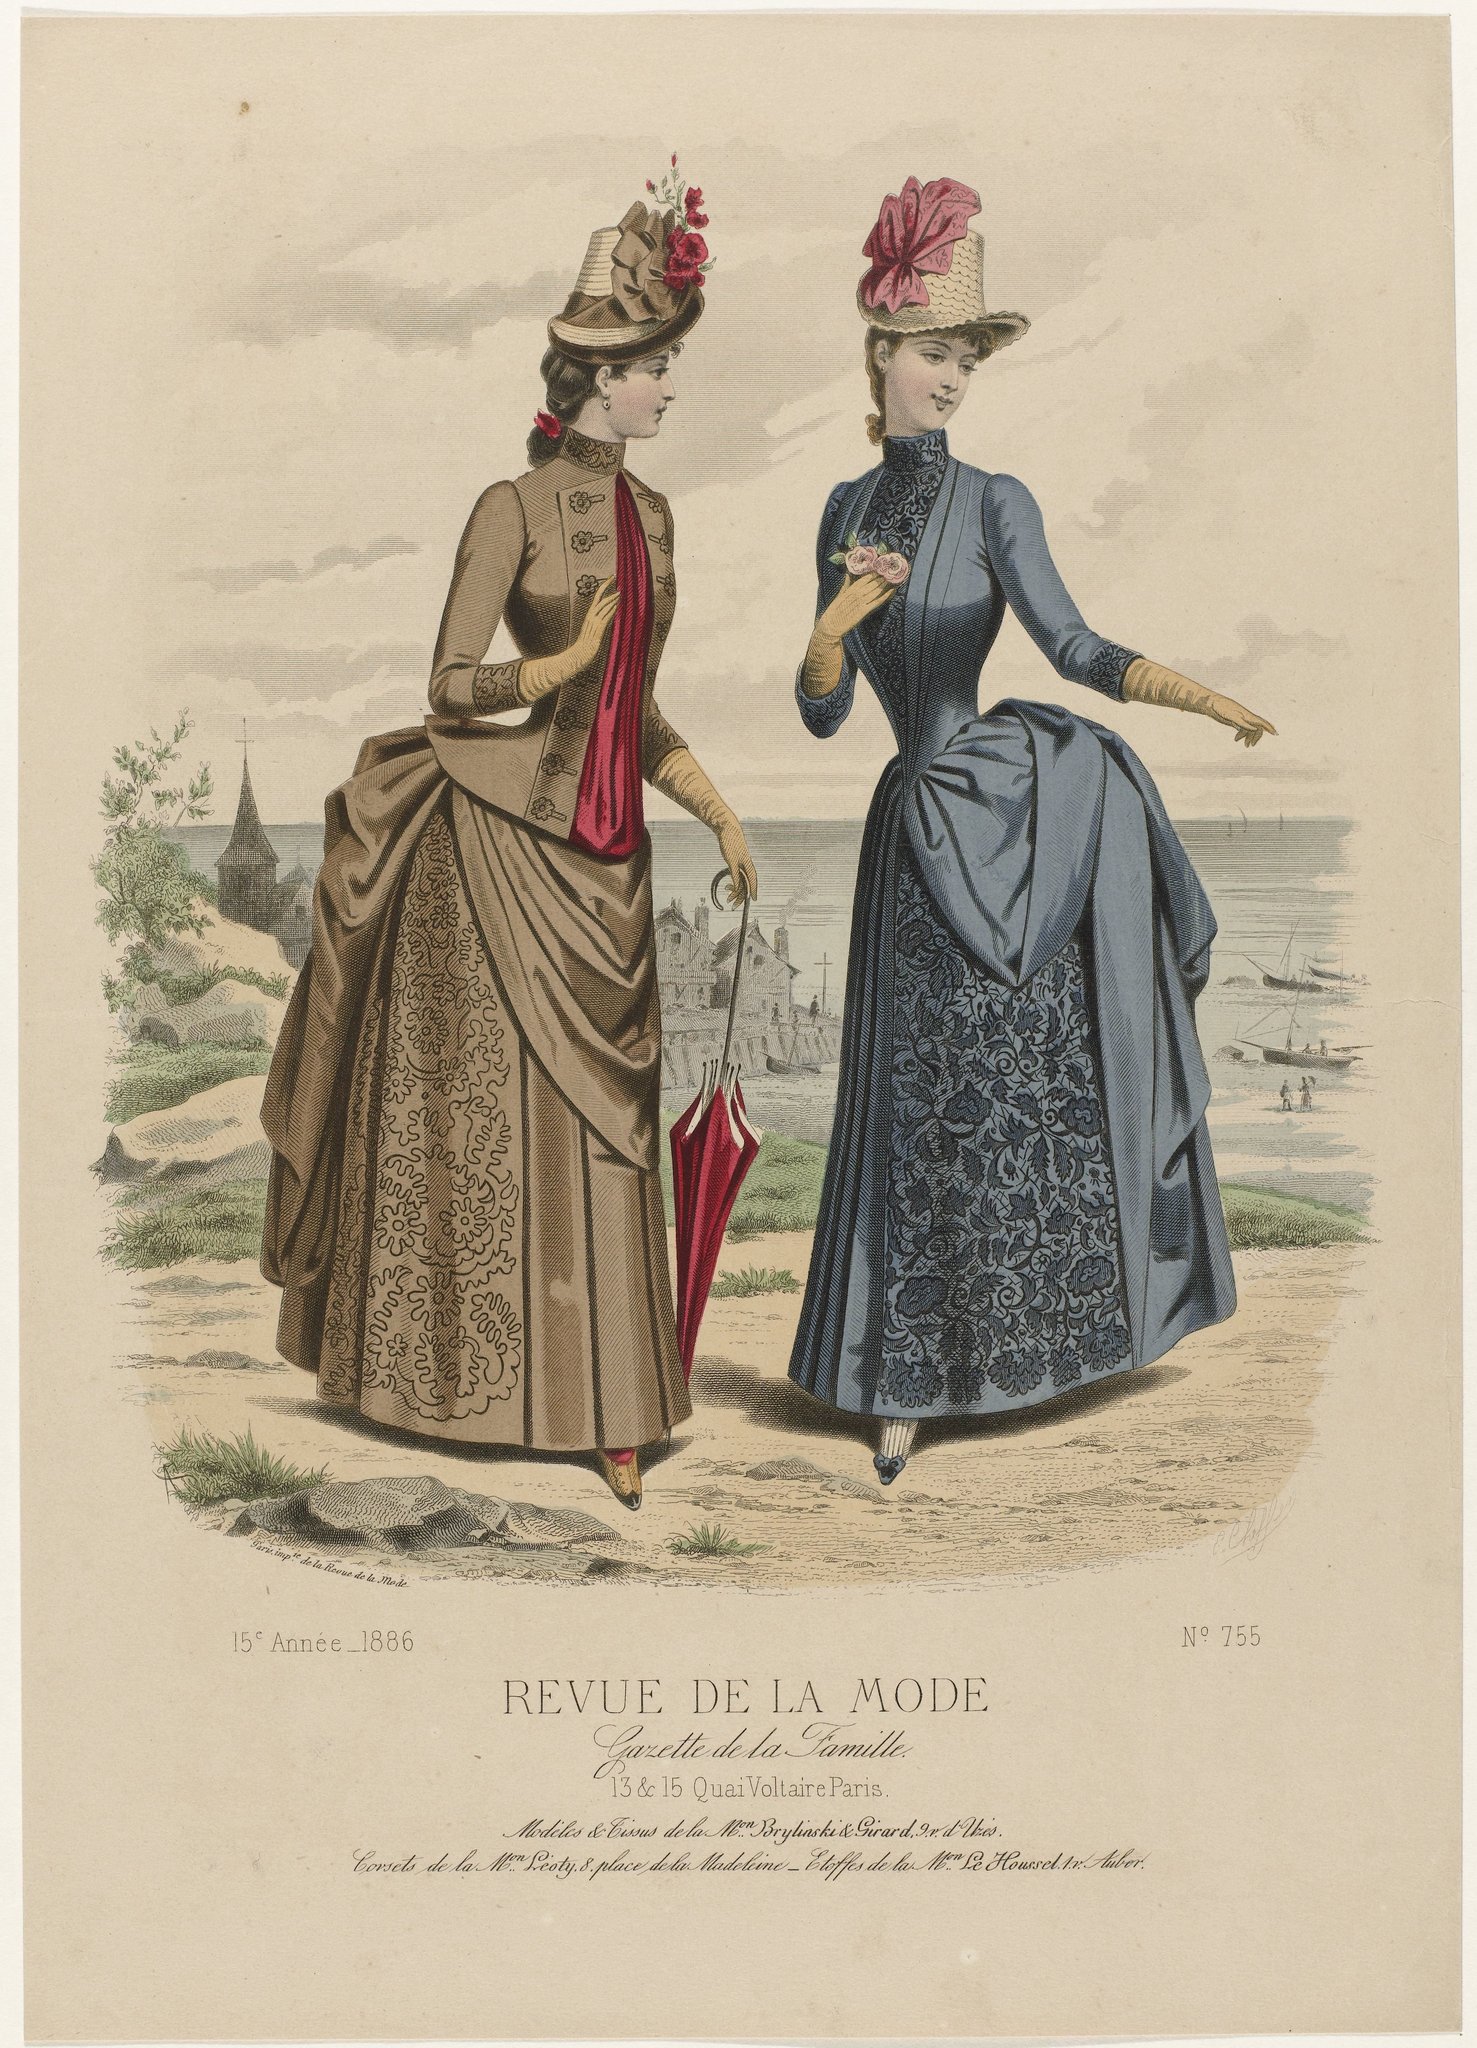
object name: fashion print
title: Revue de la Mode, Gazette de la Famille, dimanche 20 juin 1886, 15e Année, No. 755: Modèles & Tissus (...)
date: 1886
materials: paper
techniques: engraving, hand coloring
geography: paris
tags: beach (as place of recreation), cut flowers; nosegay, bunch of flowers, gloves, mittens (long gloves) (+ women's clothes), walking-stick, staff, cane (+ women's clothes), fashion plates, head-gear: hat (+ women's clothes), skirt (+ women's clothes), dress, gown (+ women's clothes)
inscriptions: title: ‘REVUE DE LA MODE / Gazette de la Famille’, caption: ‘Modèles & Tissus de la M.on Brylinski & Girard, 9, r. d'Uzés. Corsets de la M.on Léoty, 8, place de la Madeleine_ Etoffes de la M.on Le Houssel, 1, r. Auber.’, address: ‘13 & 15, Quai Voltaire Paris’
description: Twee vrouwen wandelen in de duinen, op de achtergrond het strand met enkele boten. Links: kostuum van beige wol, rode 'Surah' en zwarte soutache. Jas met revers vastgezet met grote knopen. Rechts: japon van effen grijze 'sicilienne' en gebrocheerd fluweel. Model en stoffen van maison Brylinski et Girard. Onder de voorstelling enkele regels reclametekst voor verschillende producten. Prent uit het modetijdschrift Revue de la Mode (1872-1913). Uitgebreide beschrijving van de kleding op pagina 196 en 198 "PLANCHE COLORIÉE".